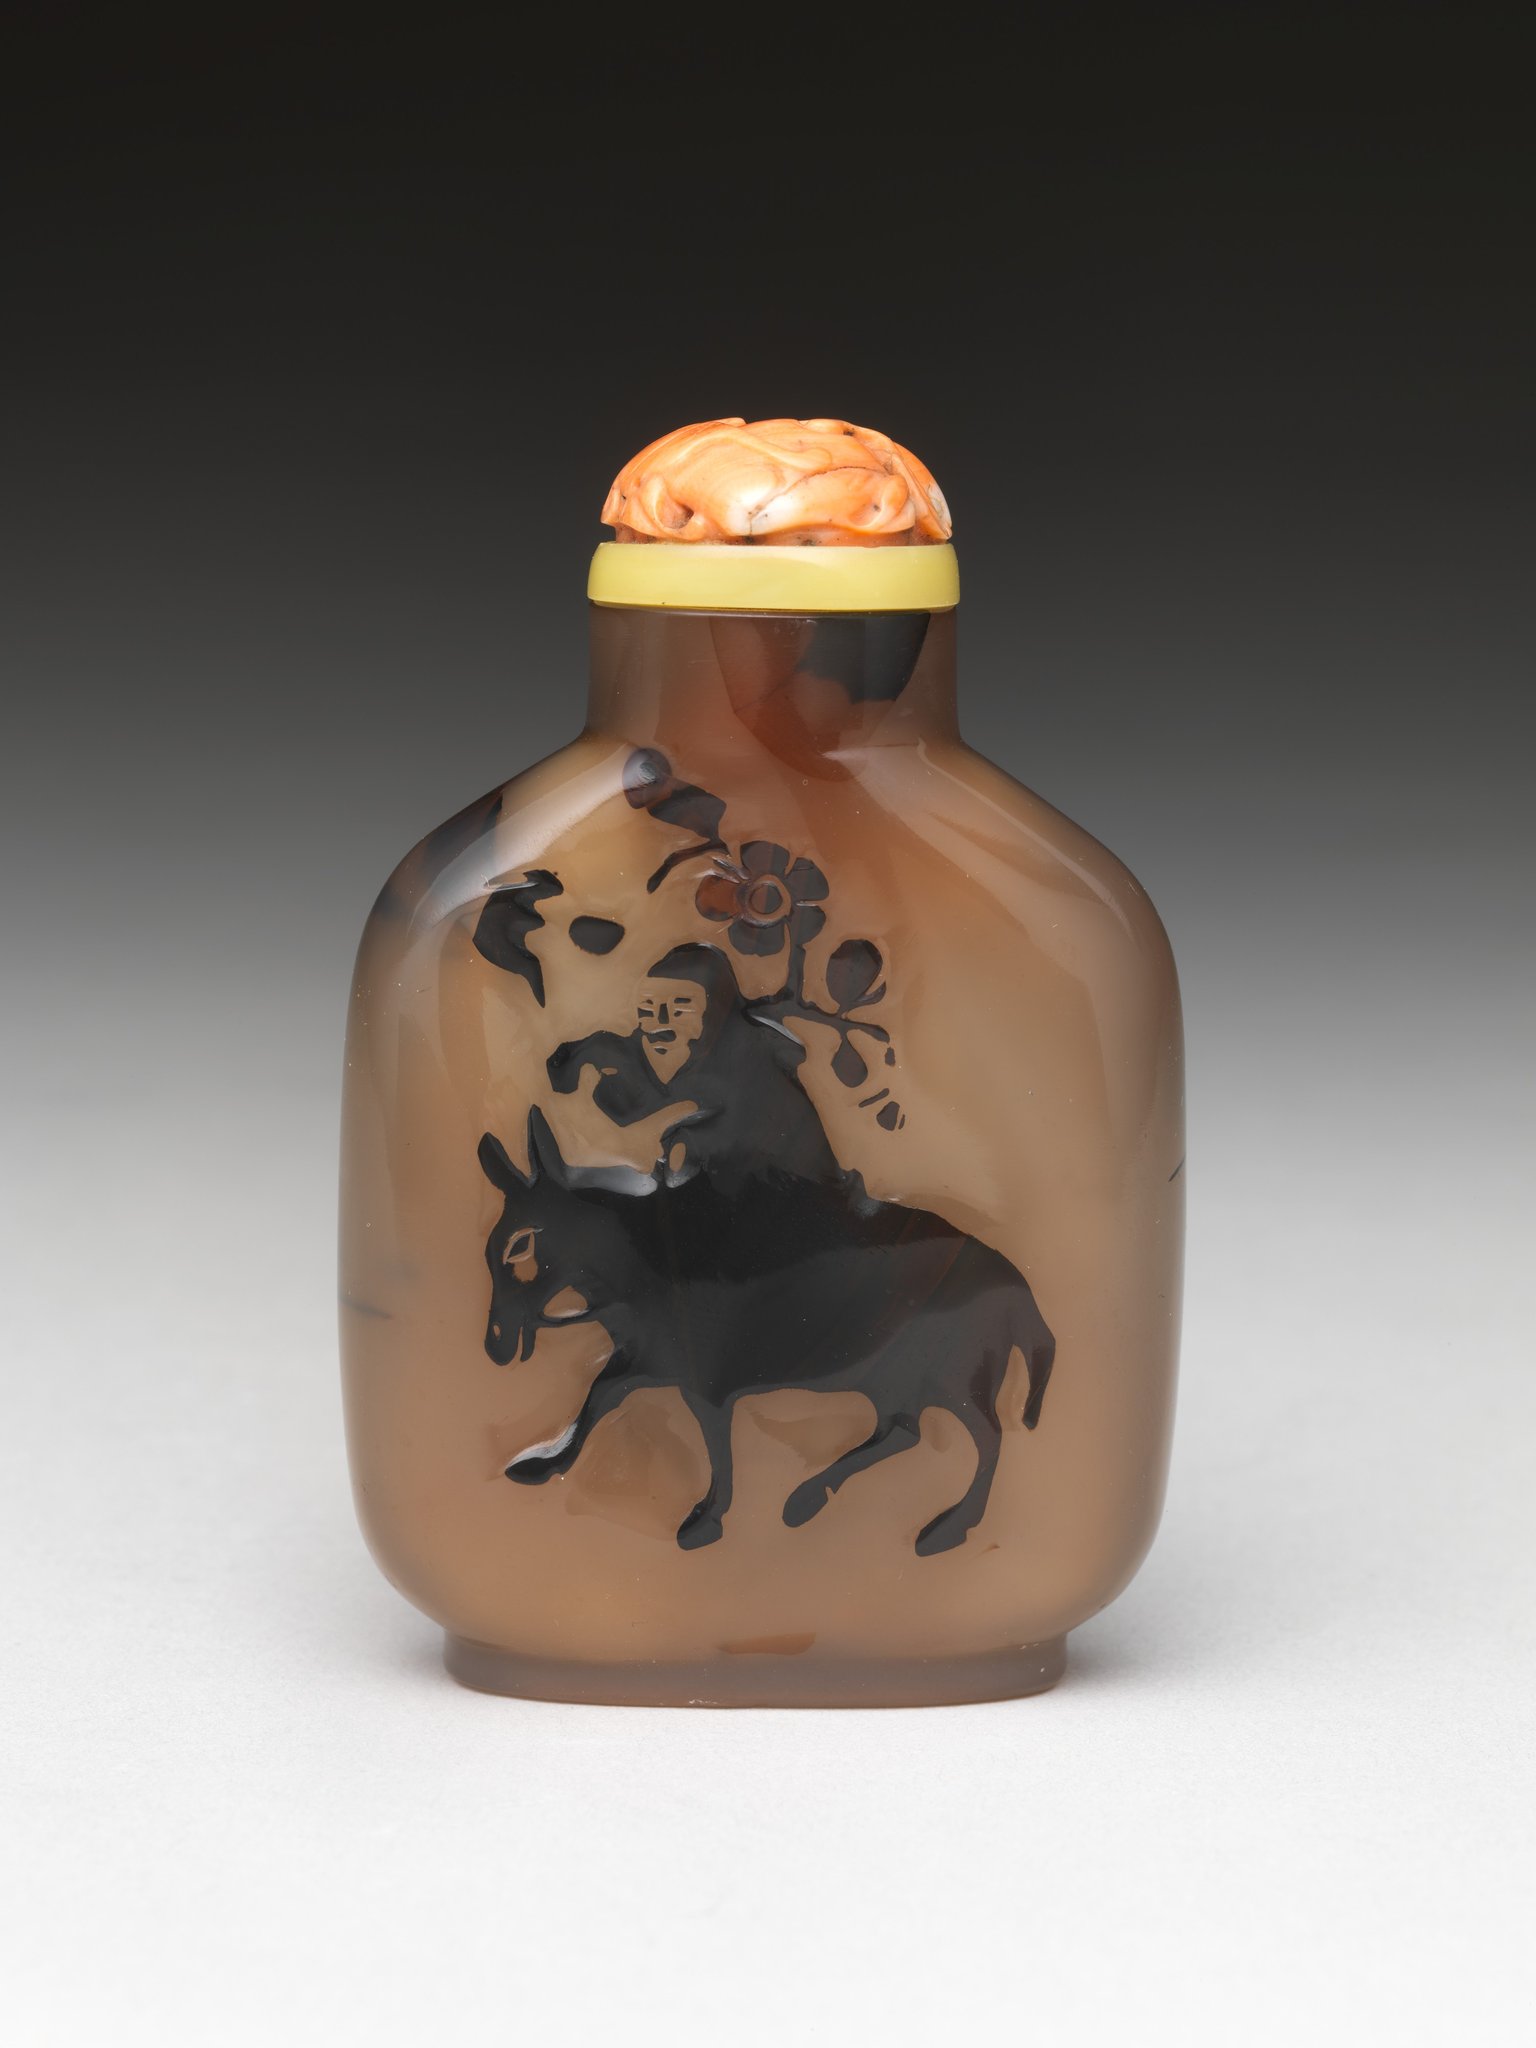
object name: snuff bottle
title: Snuff Bottle with Old Man Riding a Donkey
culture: chinese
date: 1801-1833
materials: stone, coral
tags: men,donkeys